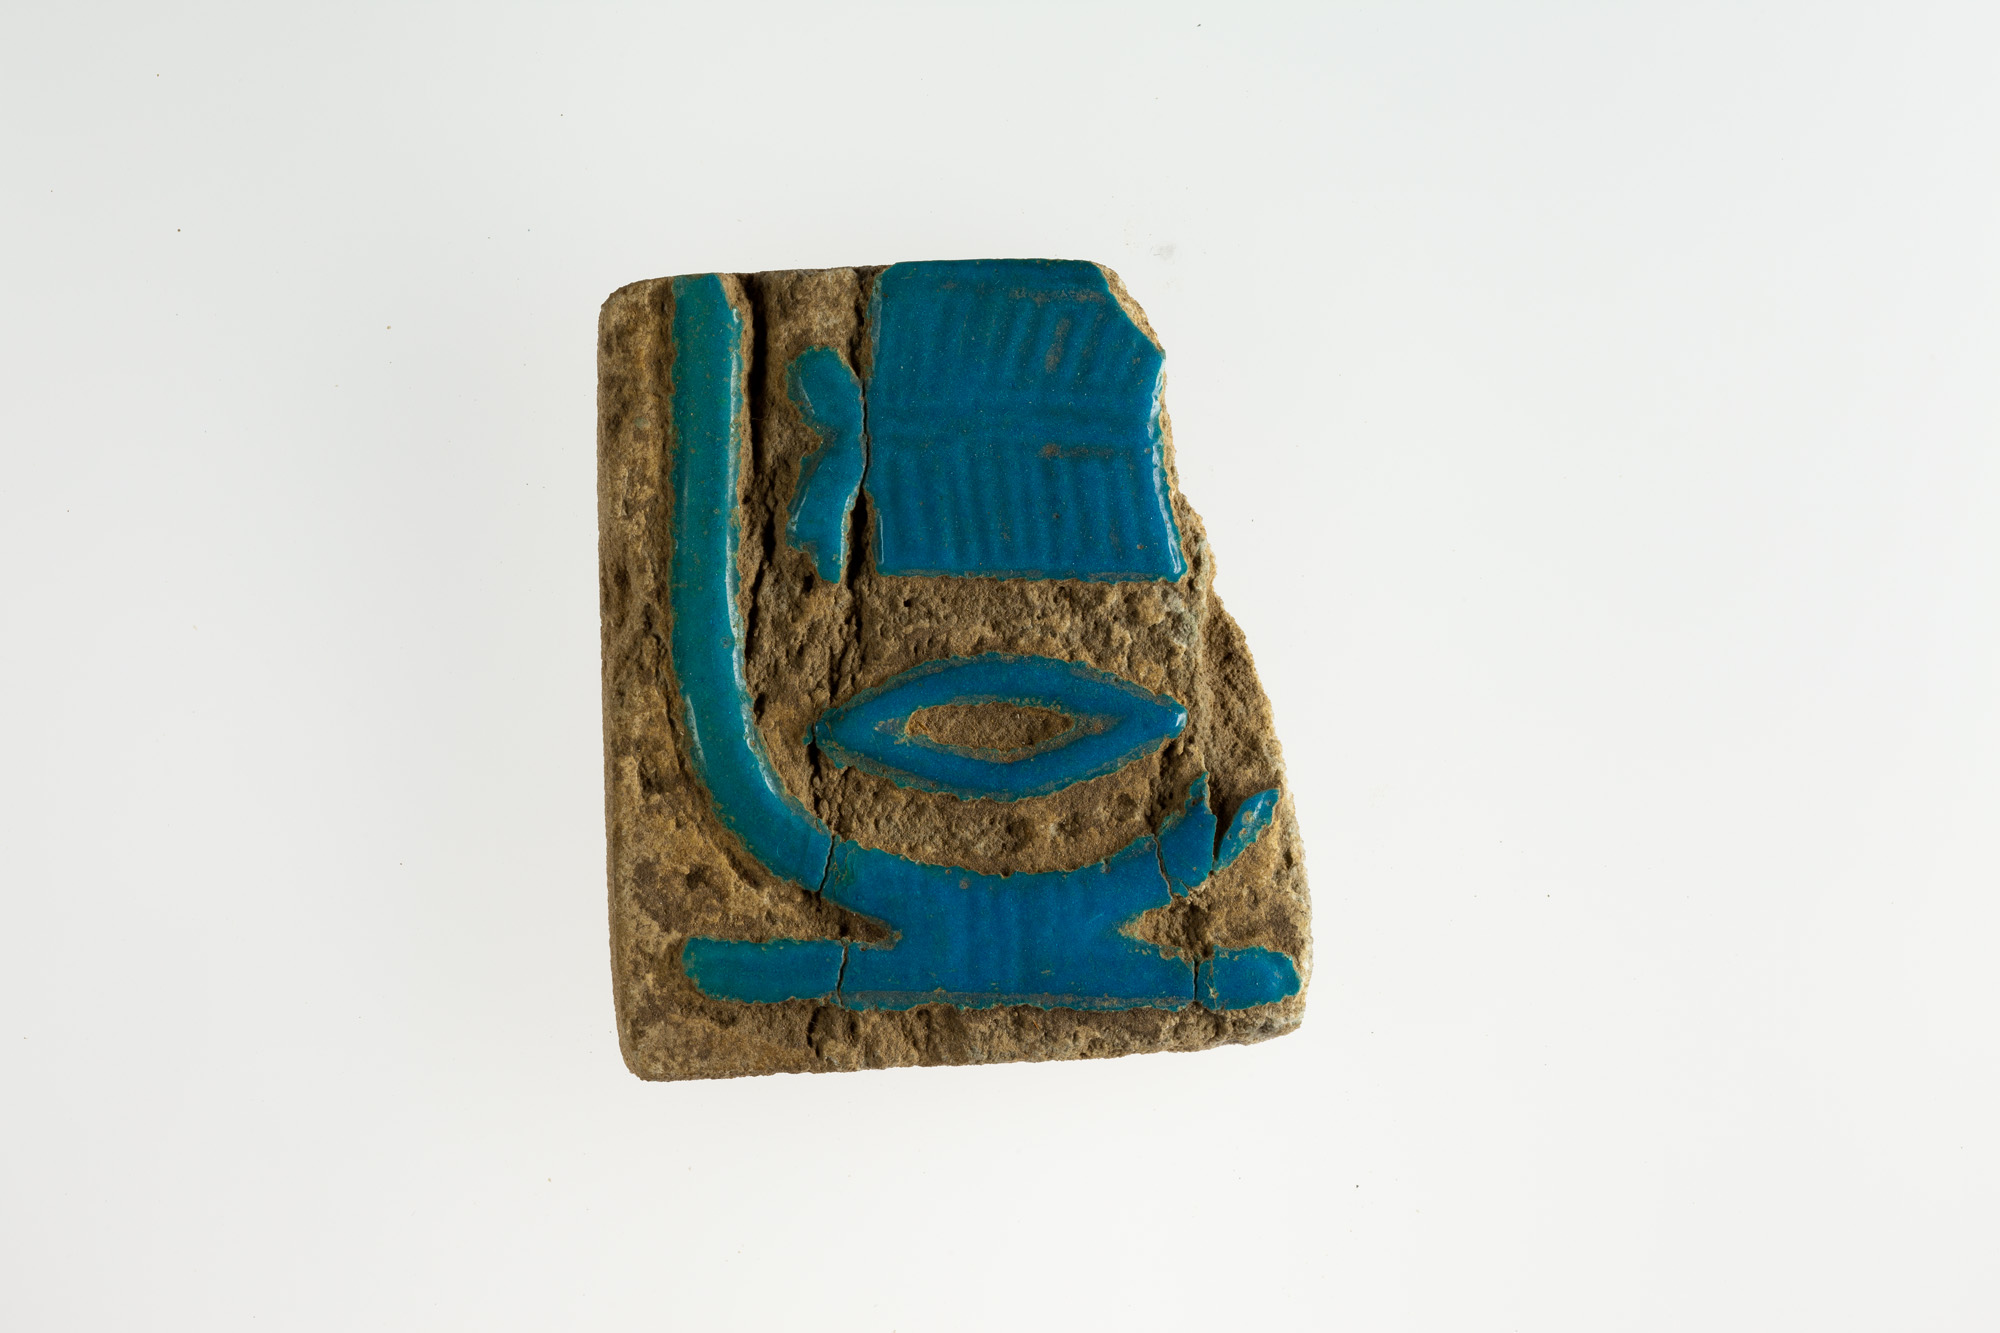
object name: tile, khendjer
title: Fragment of a Tile with the Name of King Khendjer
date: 1763-1758 BCE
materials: faience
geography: egypt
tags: cartouches,hieroglyphs